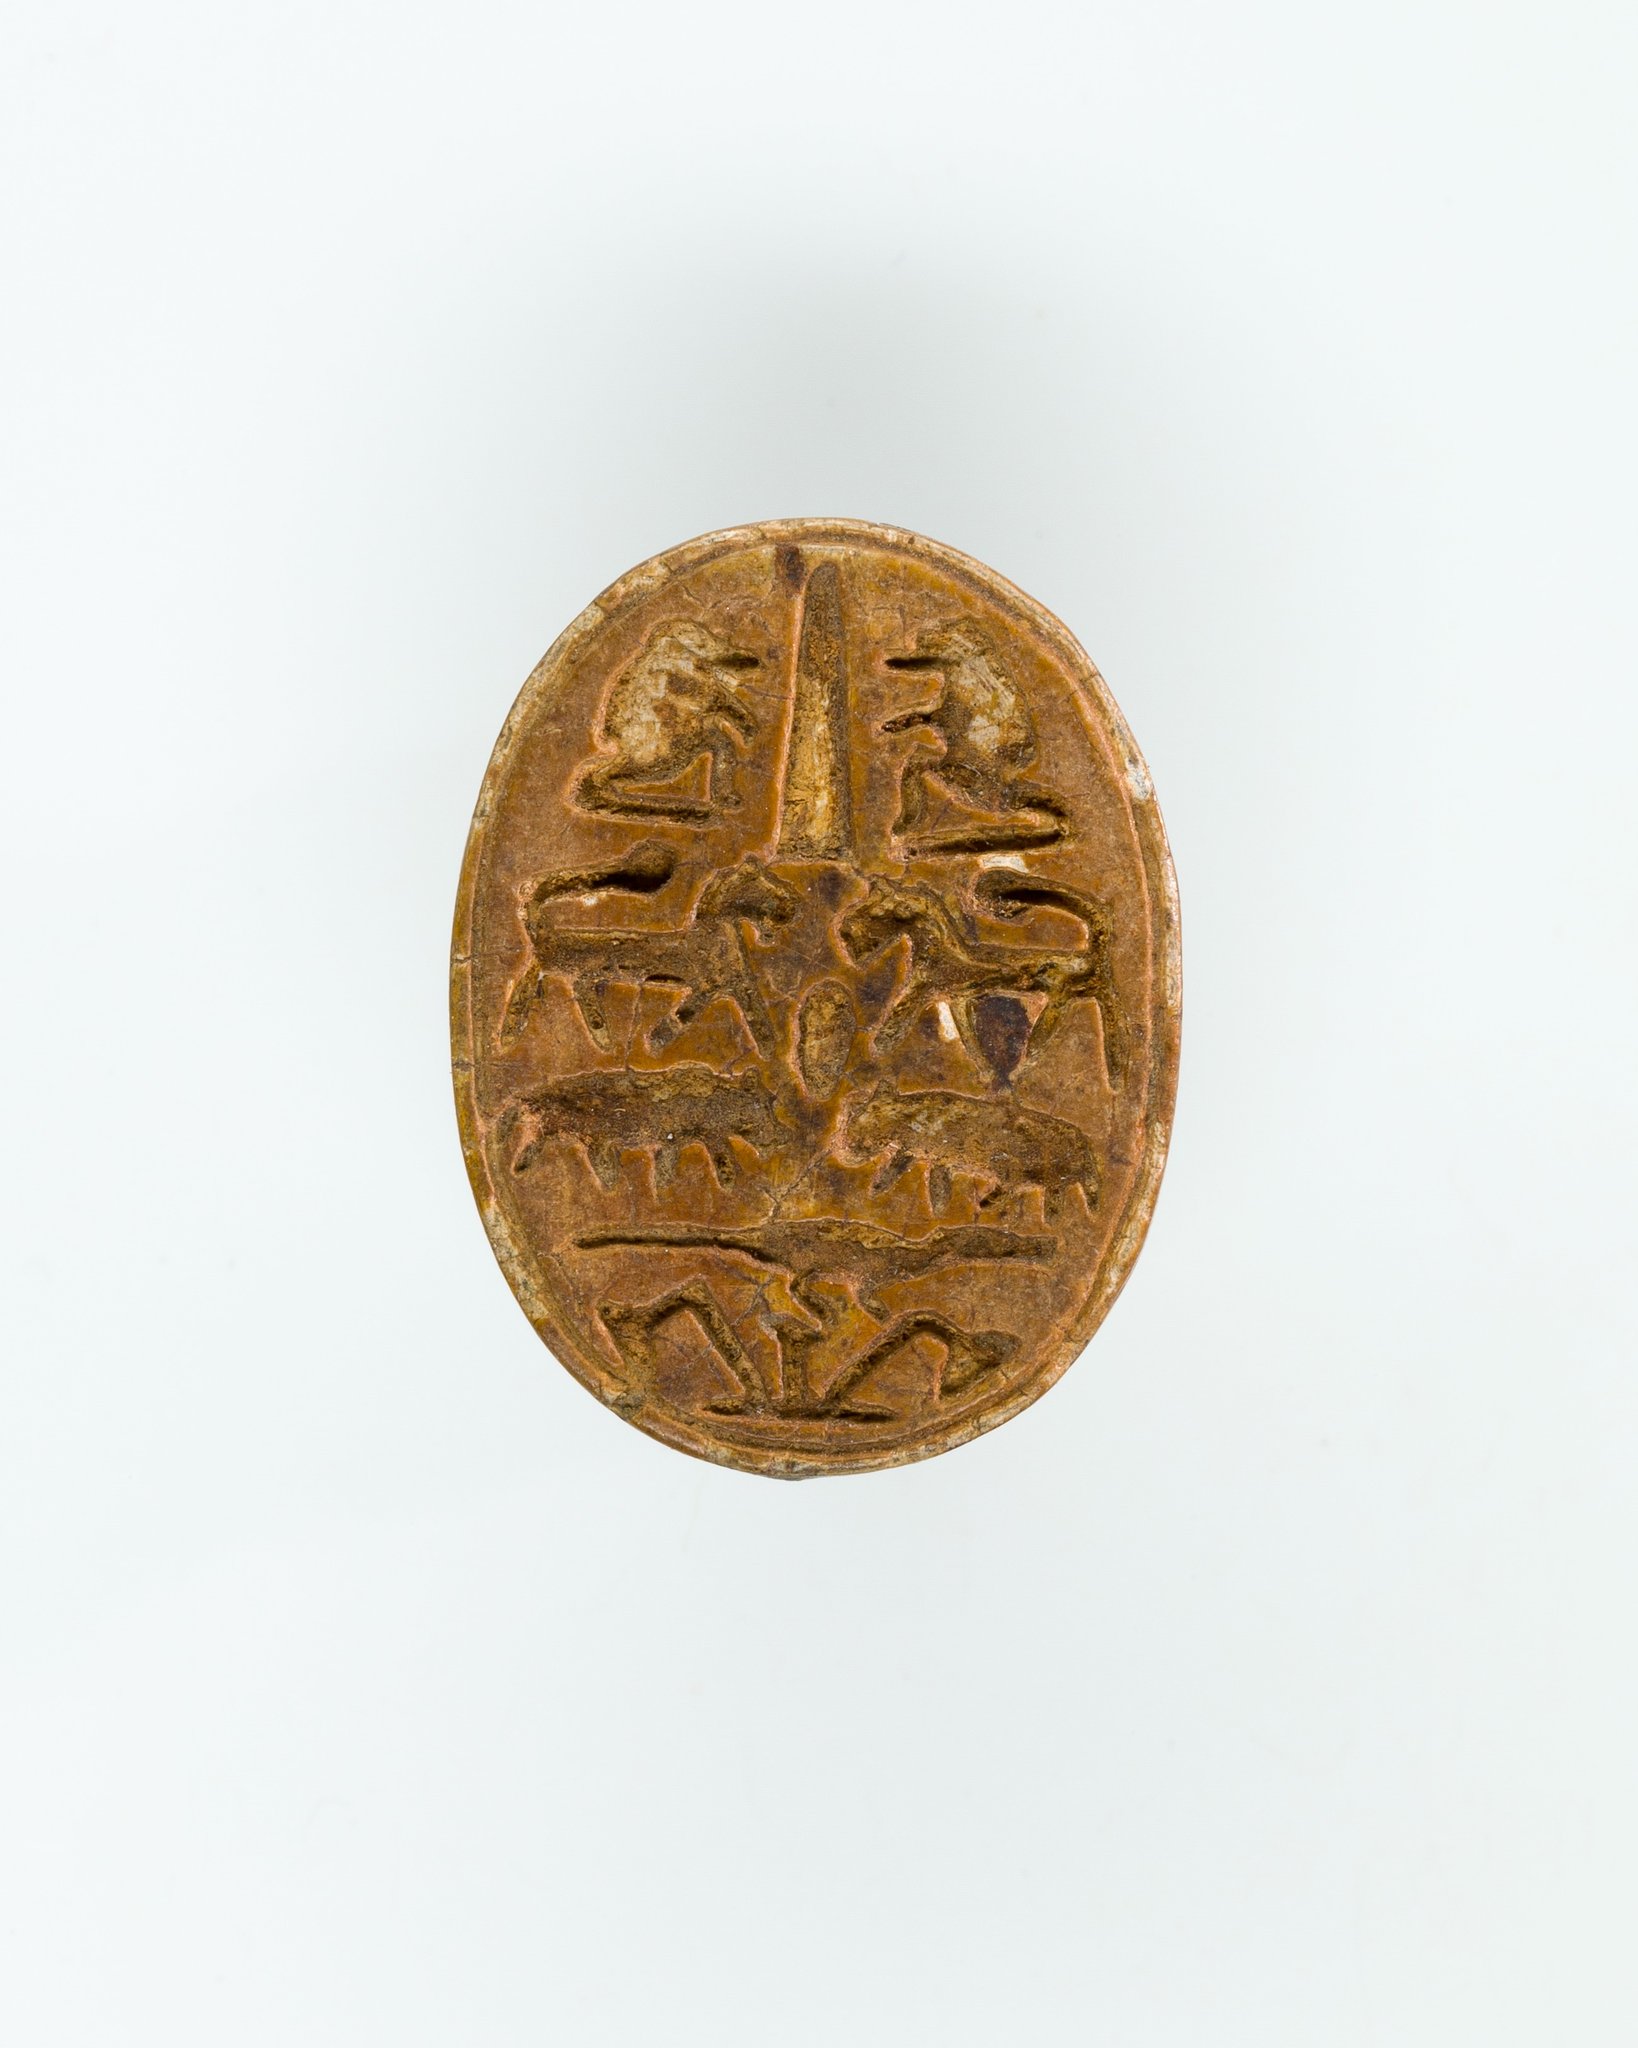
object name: scarab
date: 1295-1186 BCE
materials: stone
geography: egypt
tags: hieroglyphs,scarabs